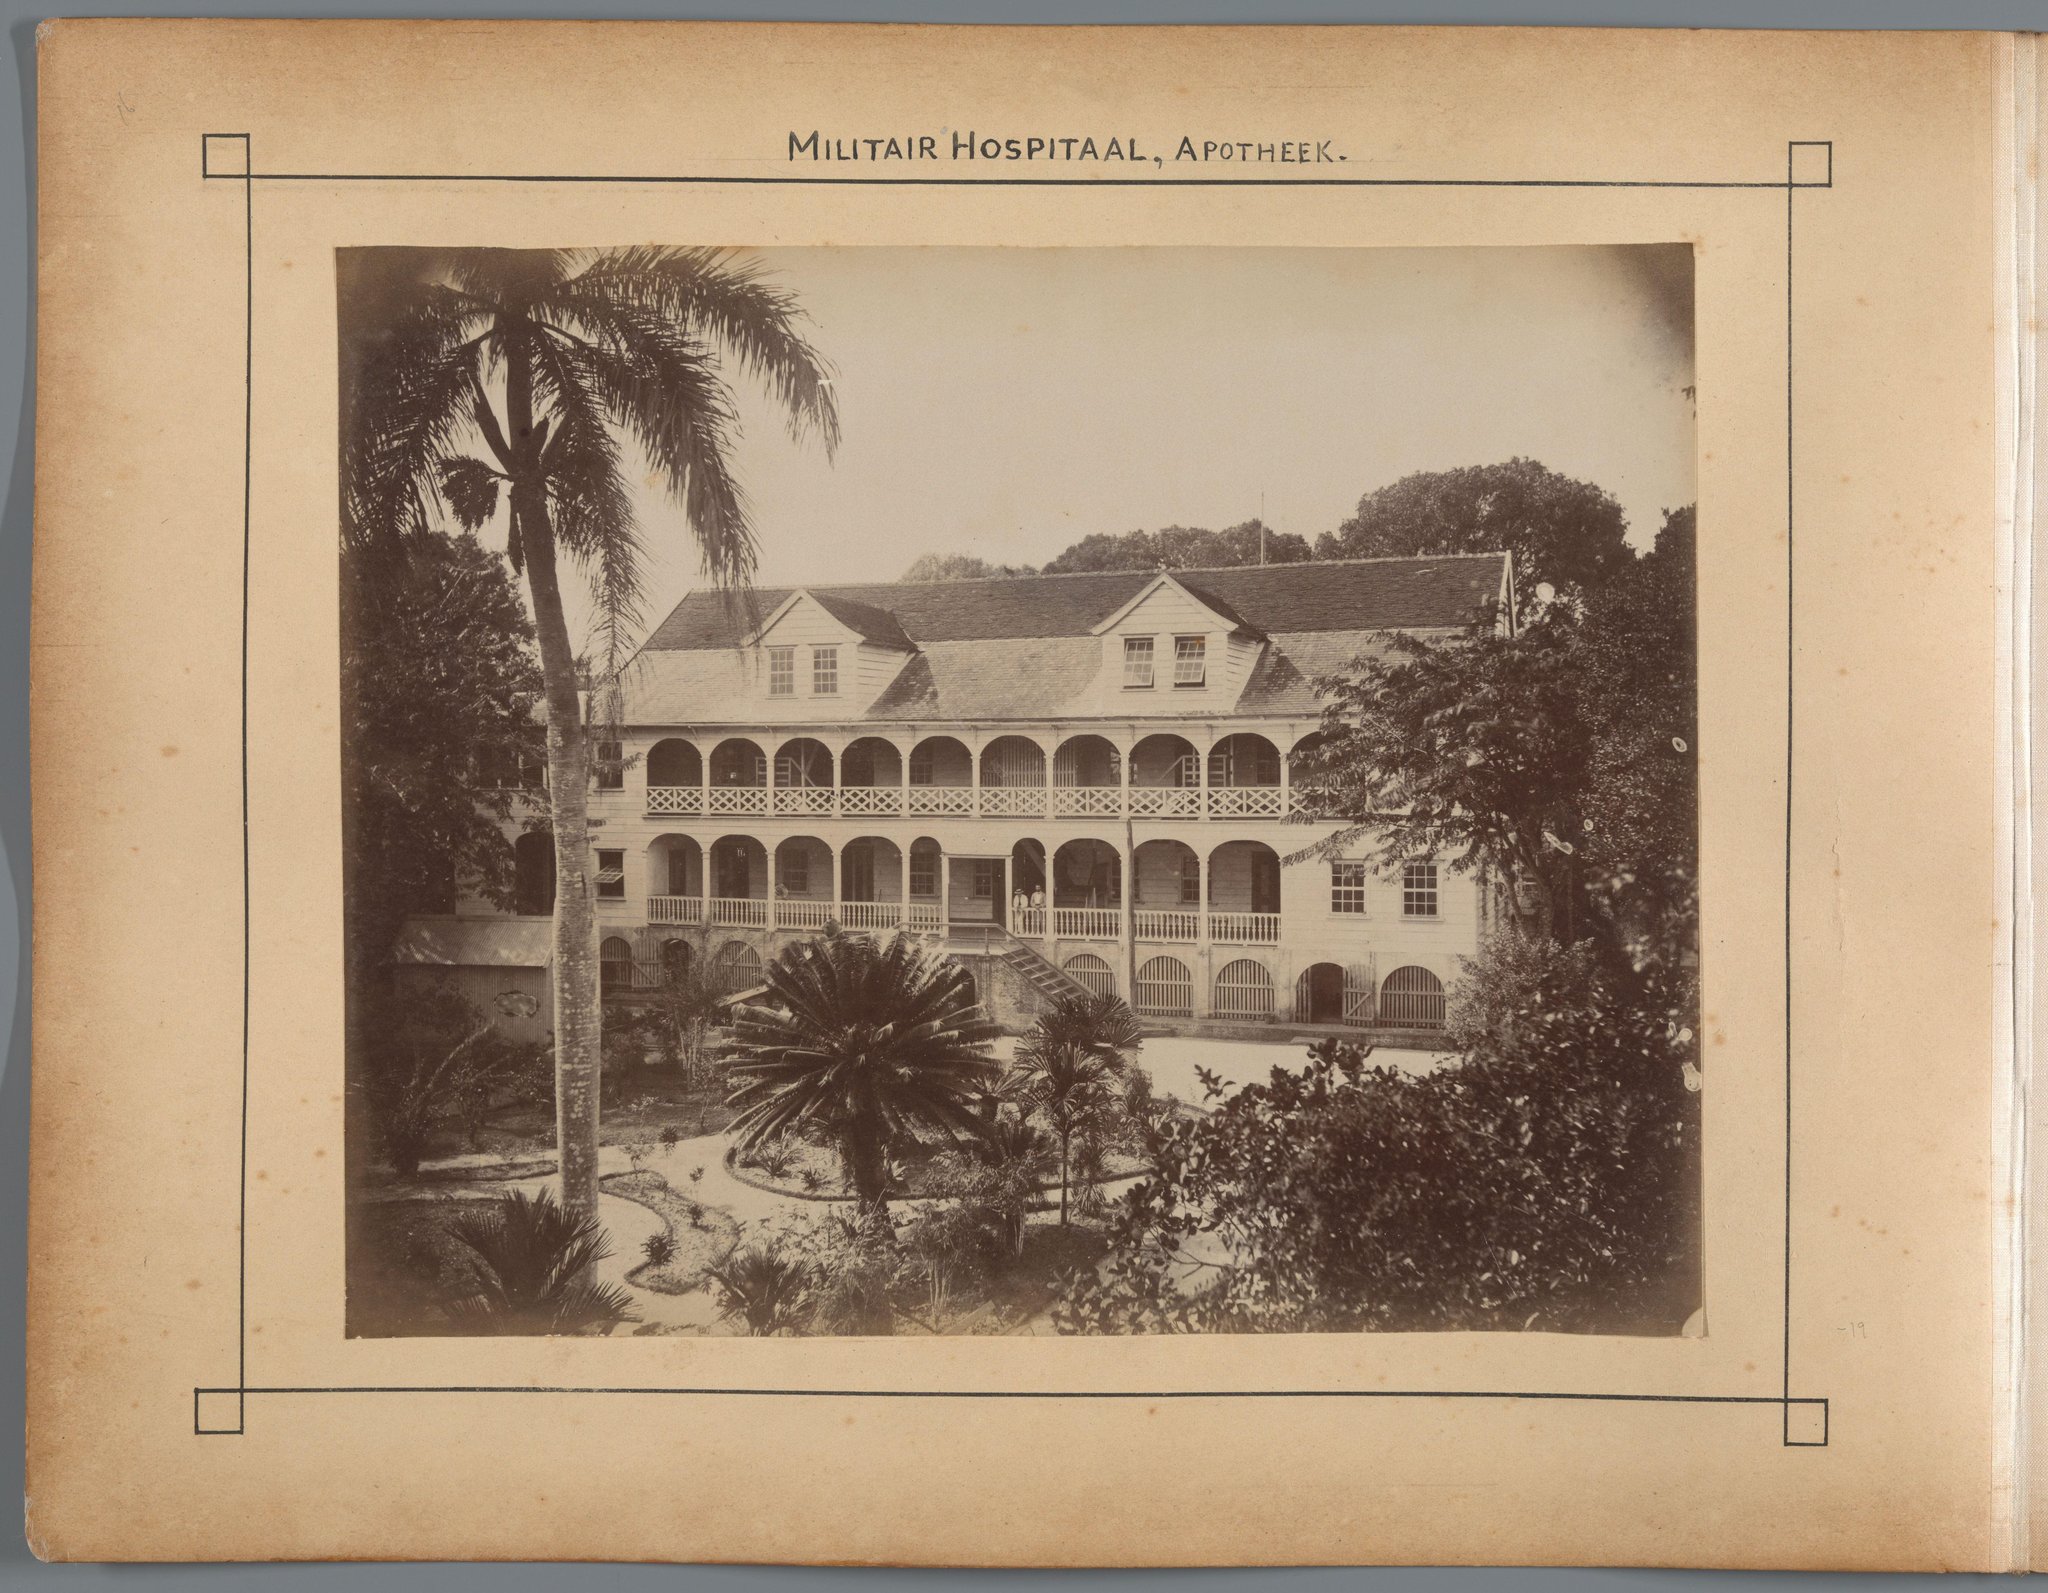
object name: photograph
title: Vogelvluchtperspectief Paramaribo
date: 1882-1902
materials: photographic support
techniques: albumen print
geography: suriname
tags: suriname